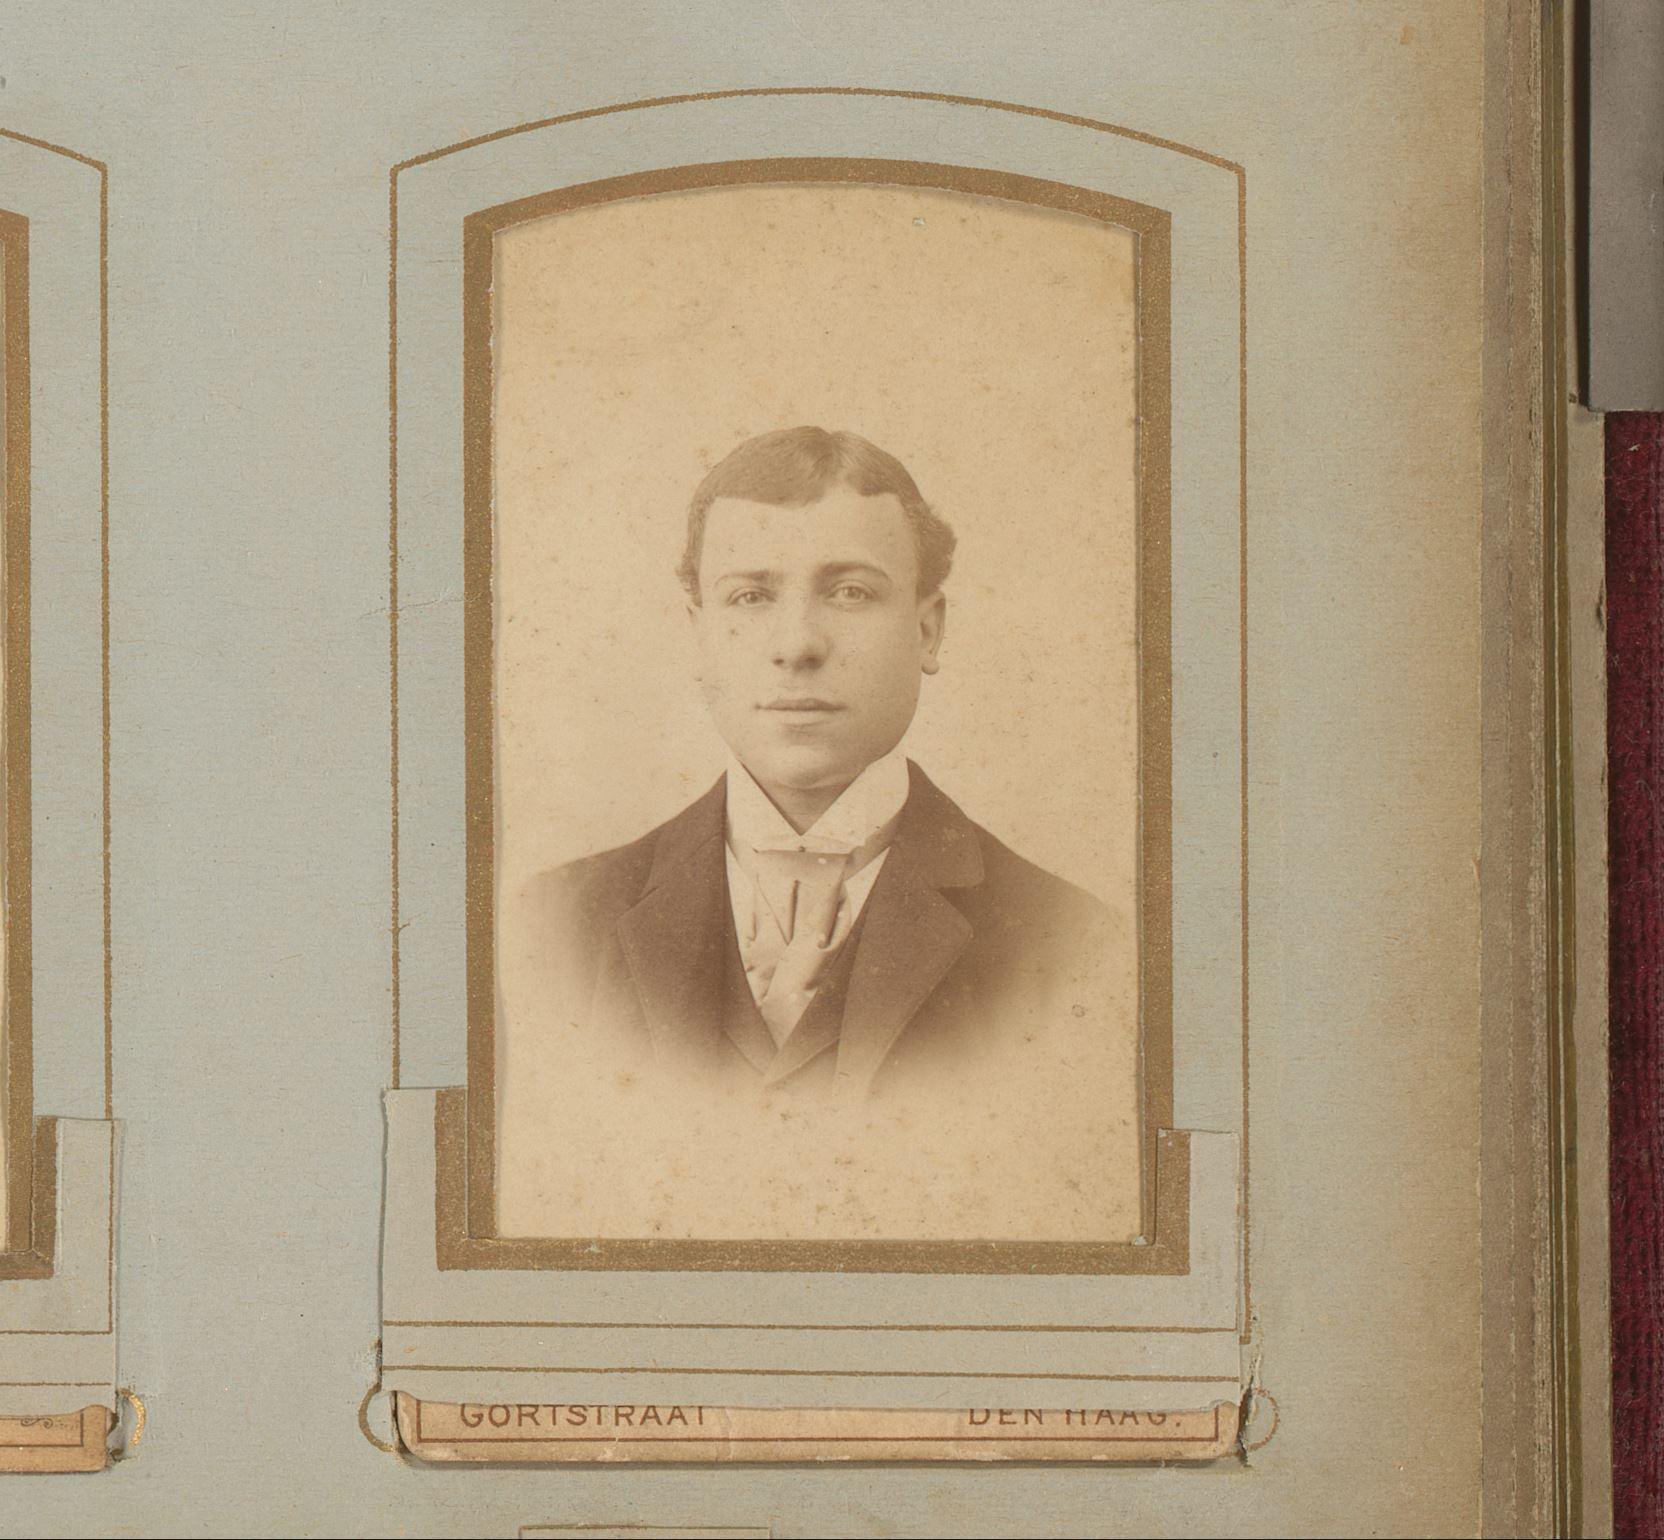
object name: album leaf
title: Portret van een jongeman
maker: wilhelm frederick antonius delboy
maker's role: fotograaf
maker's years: 1853-1928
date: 1860-1900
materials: cardboard, photographic support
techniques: albumen print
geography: the hague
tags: youth, adolescent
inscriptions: inscription: ‘Gortstraat/ Den Haag’